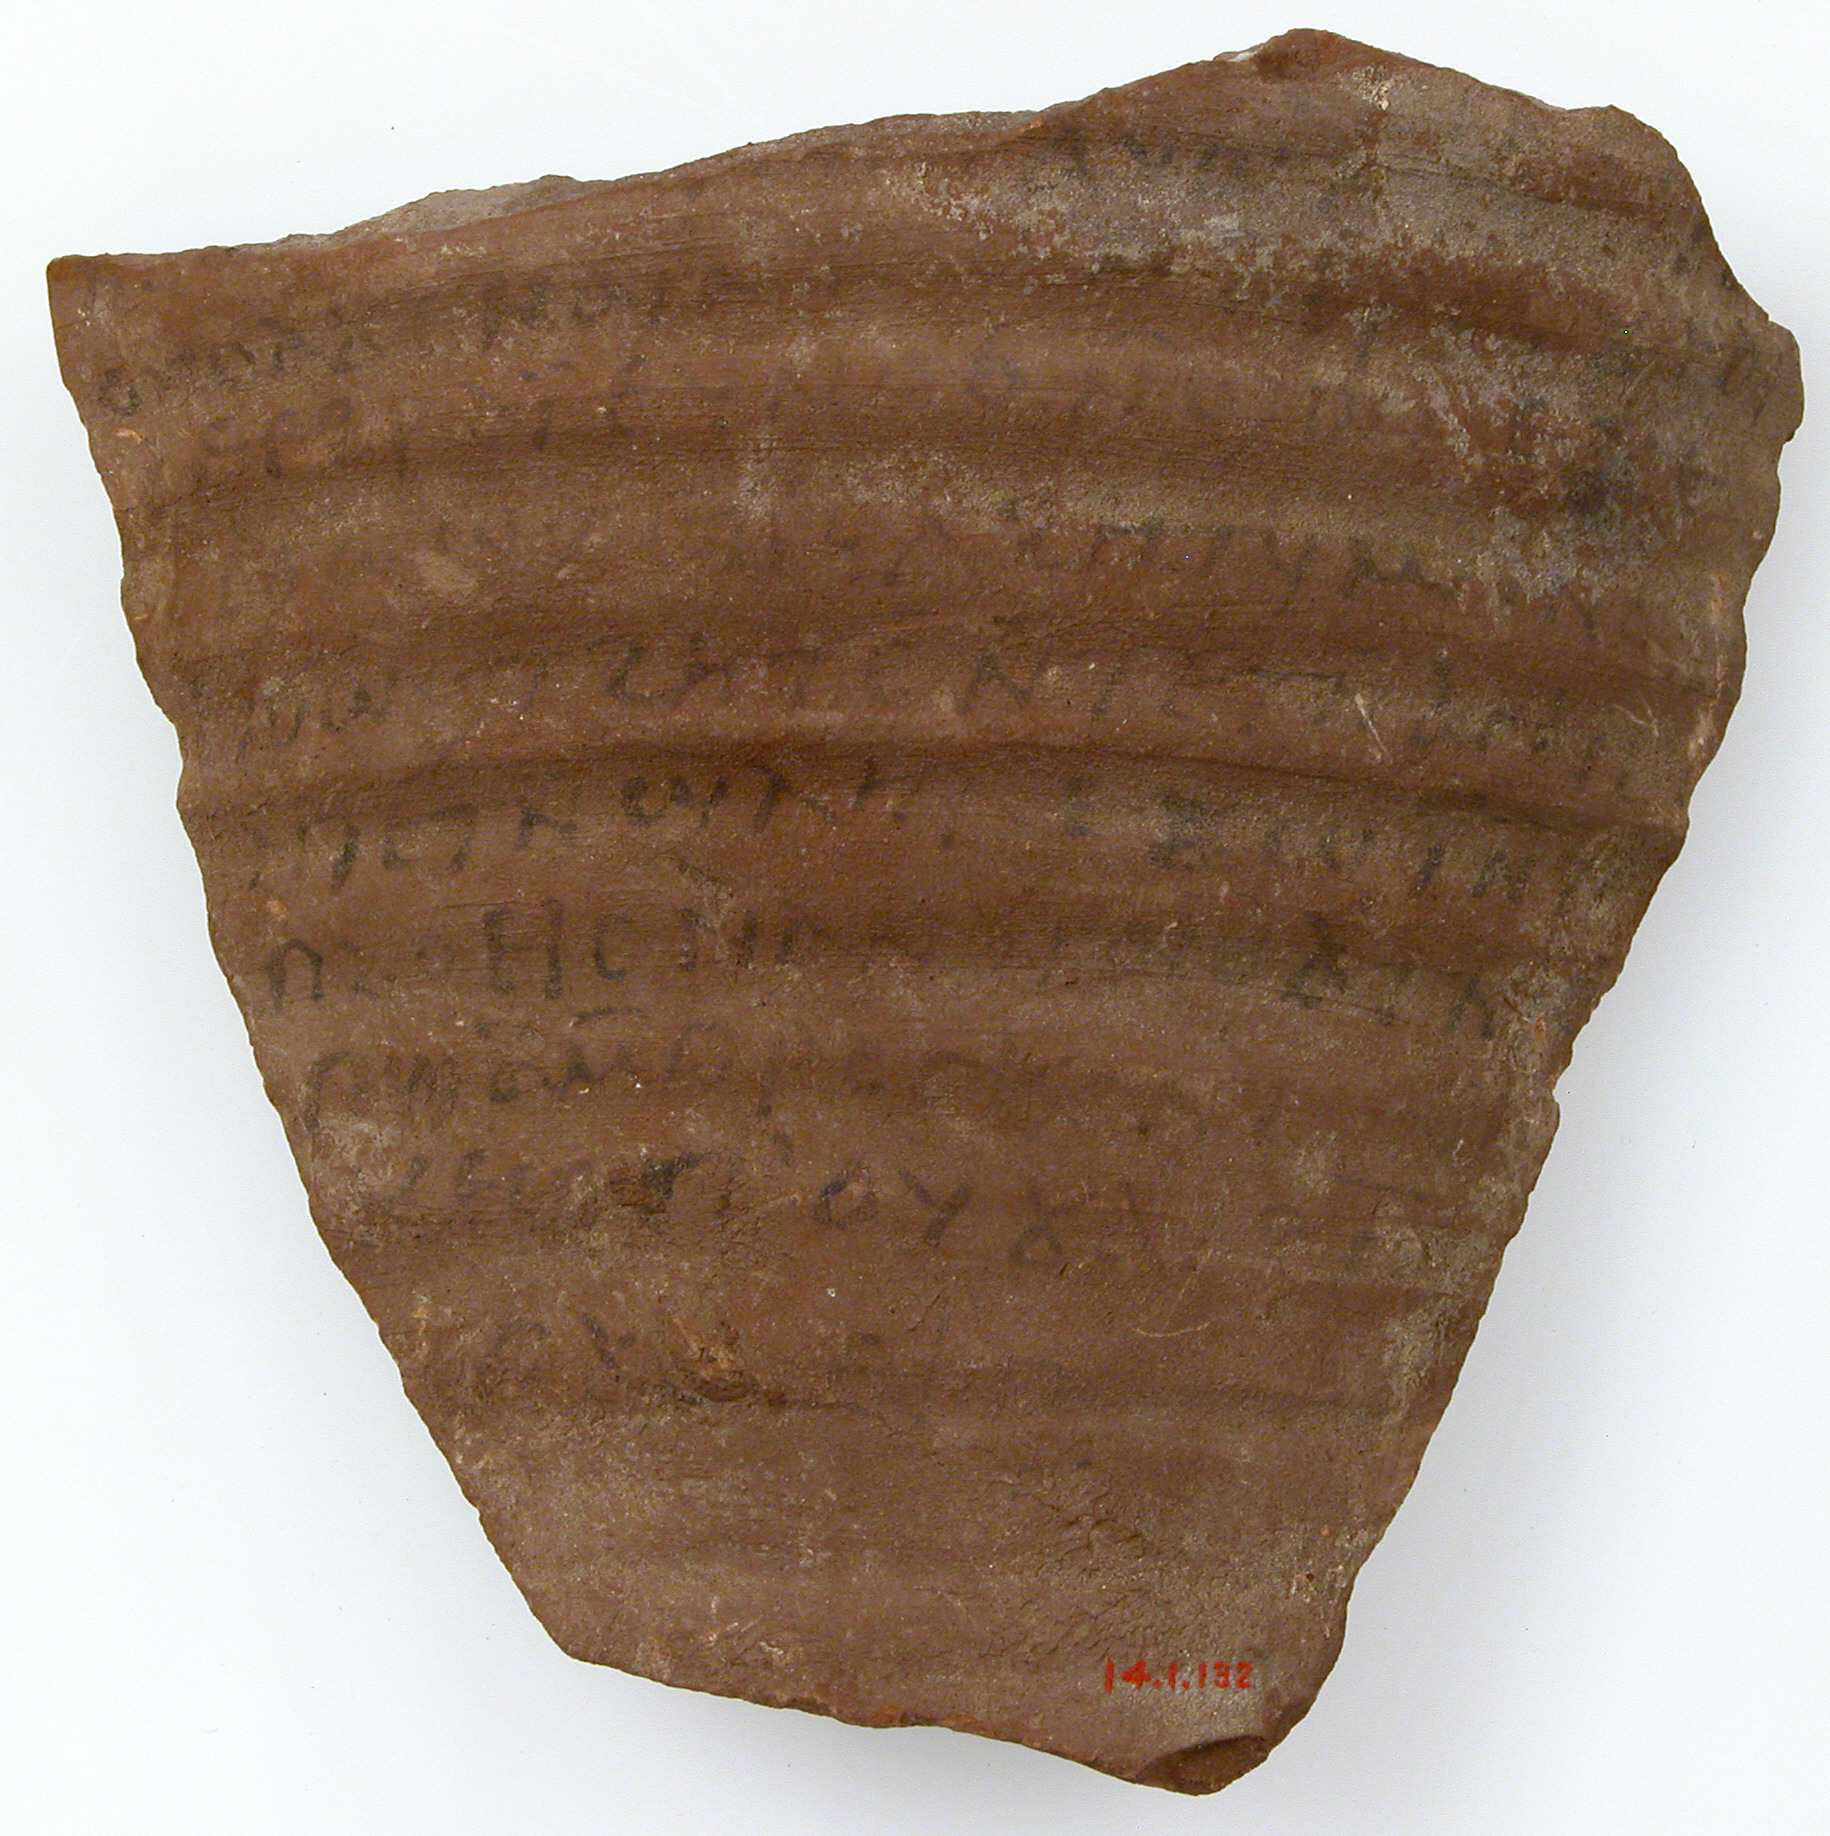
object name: ostrakon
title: Ostrakon with a Letter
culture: coptic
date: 600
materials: ink, pottery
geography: egypt